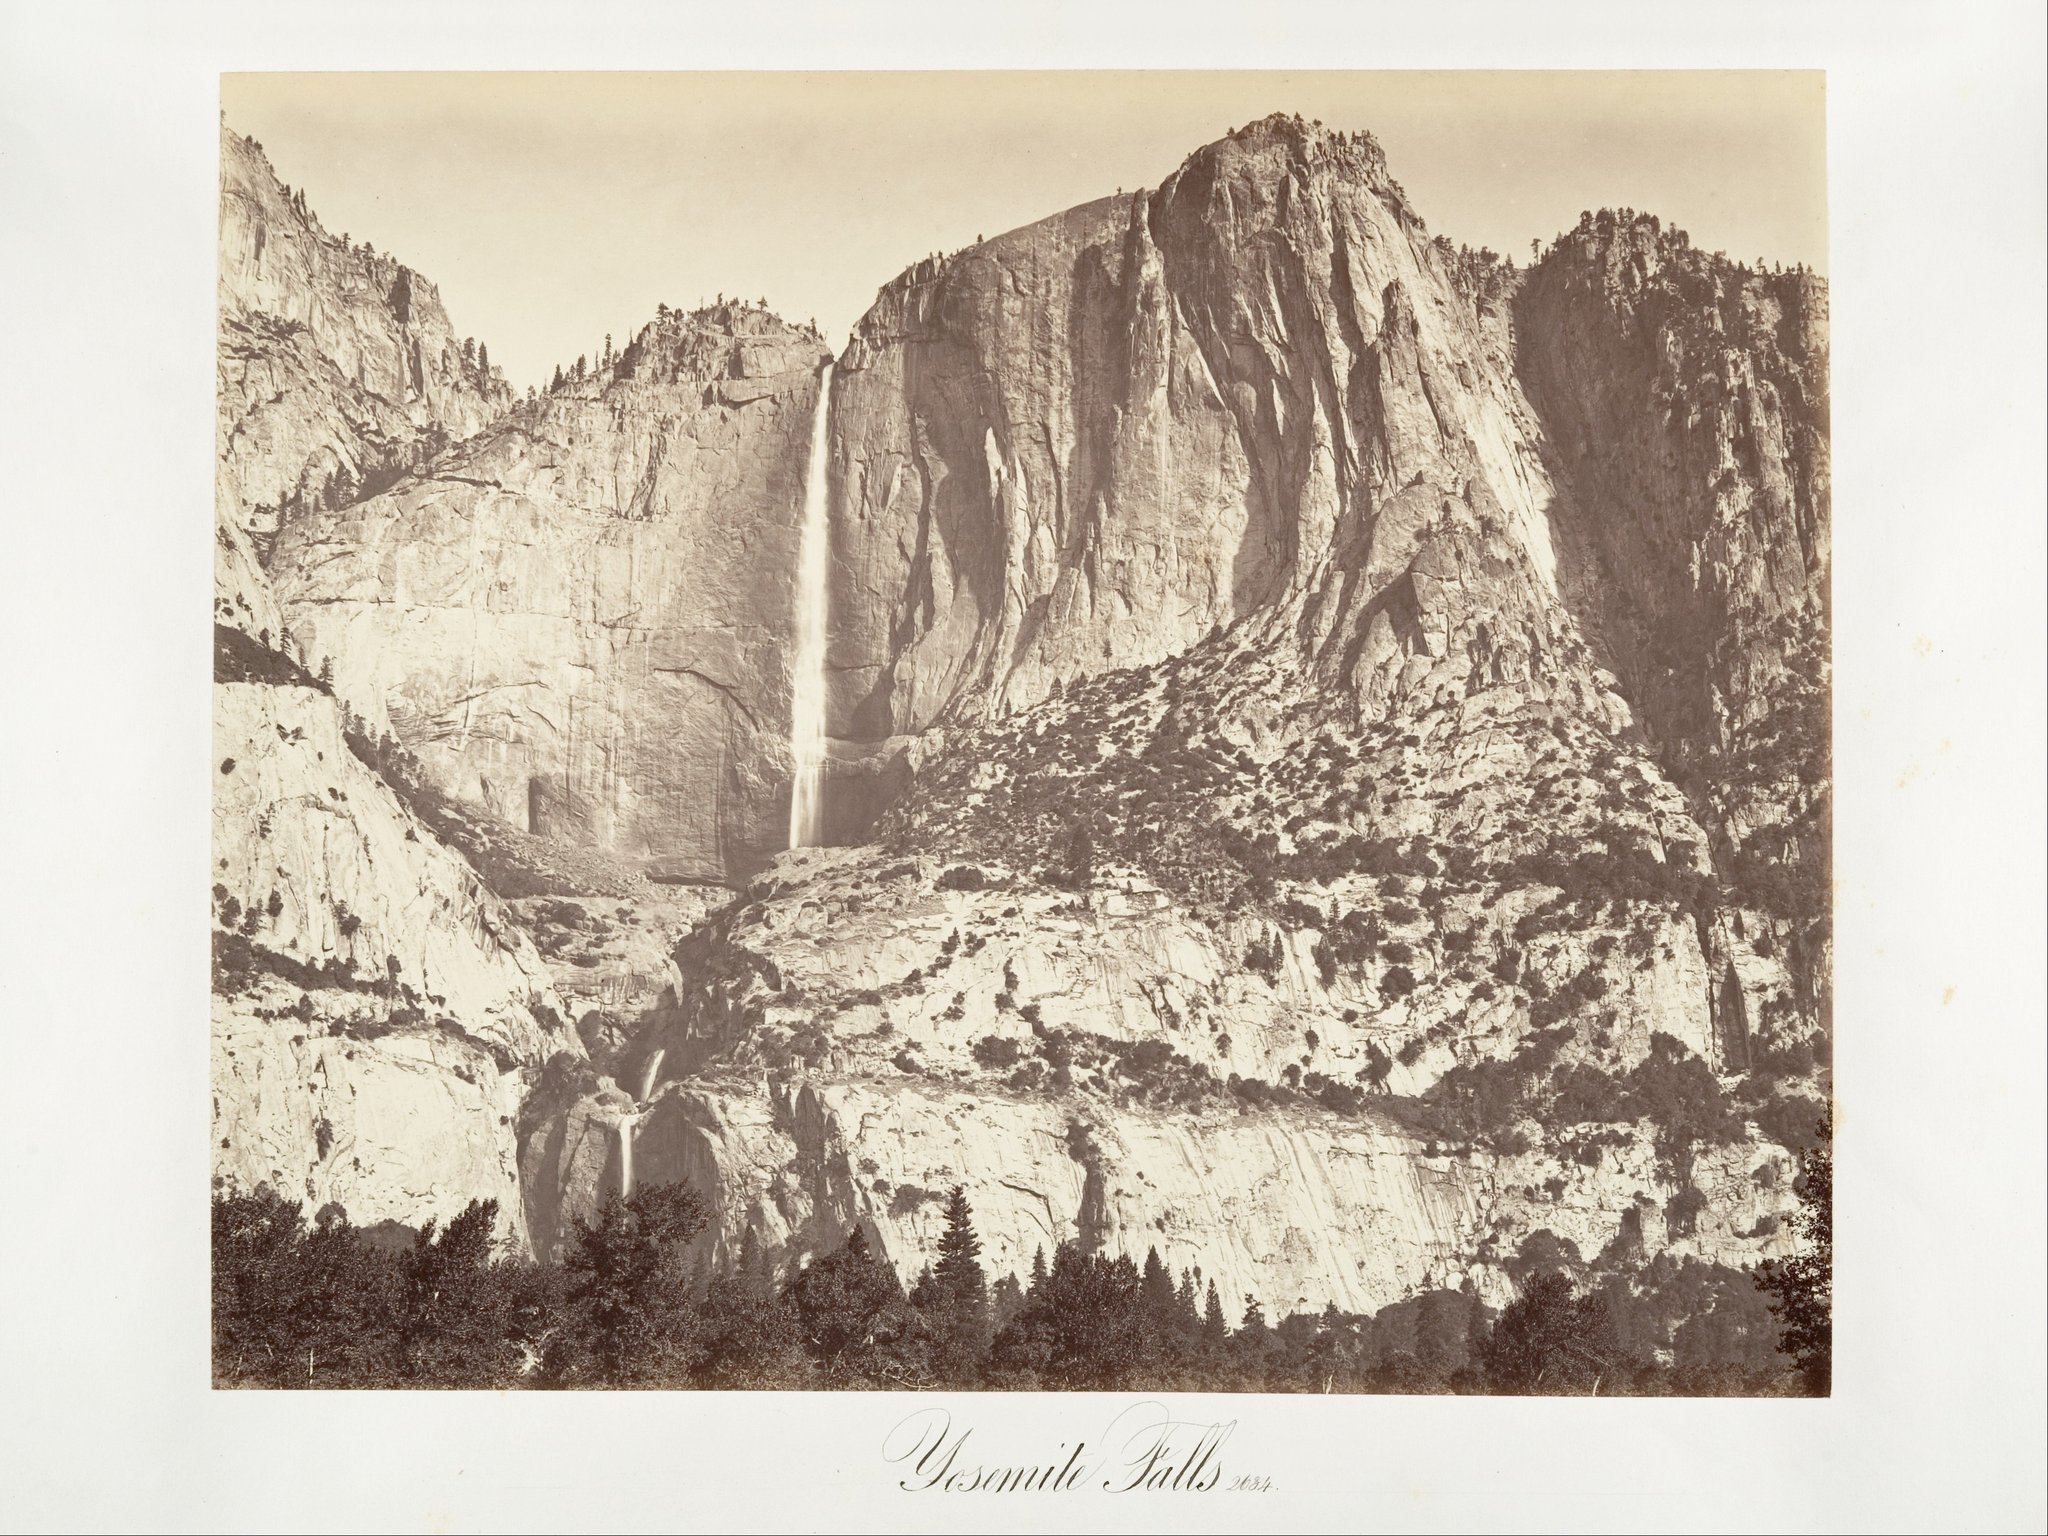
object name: photograph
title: Yosemite Falls, 2,634 feet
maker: carleton e. watkins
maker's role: artist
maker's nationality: american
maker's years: 1829-1916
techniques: albumen silver print, glass negative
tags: waterfalls,mountains,landscapes